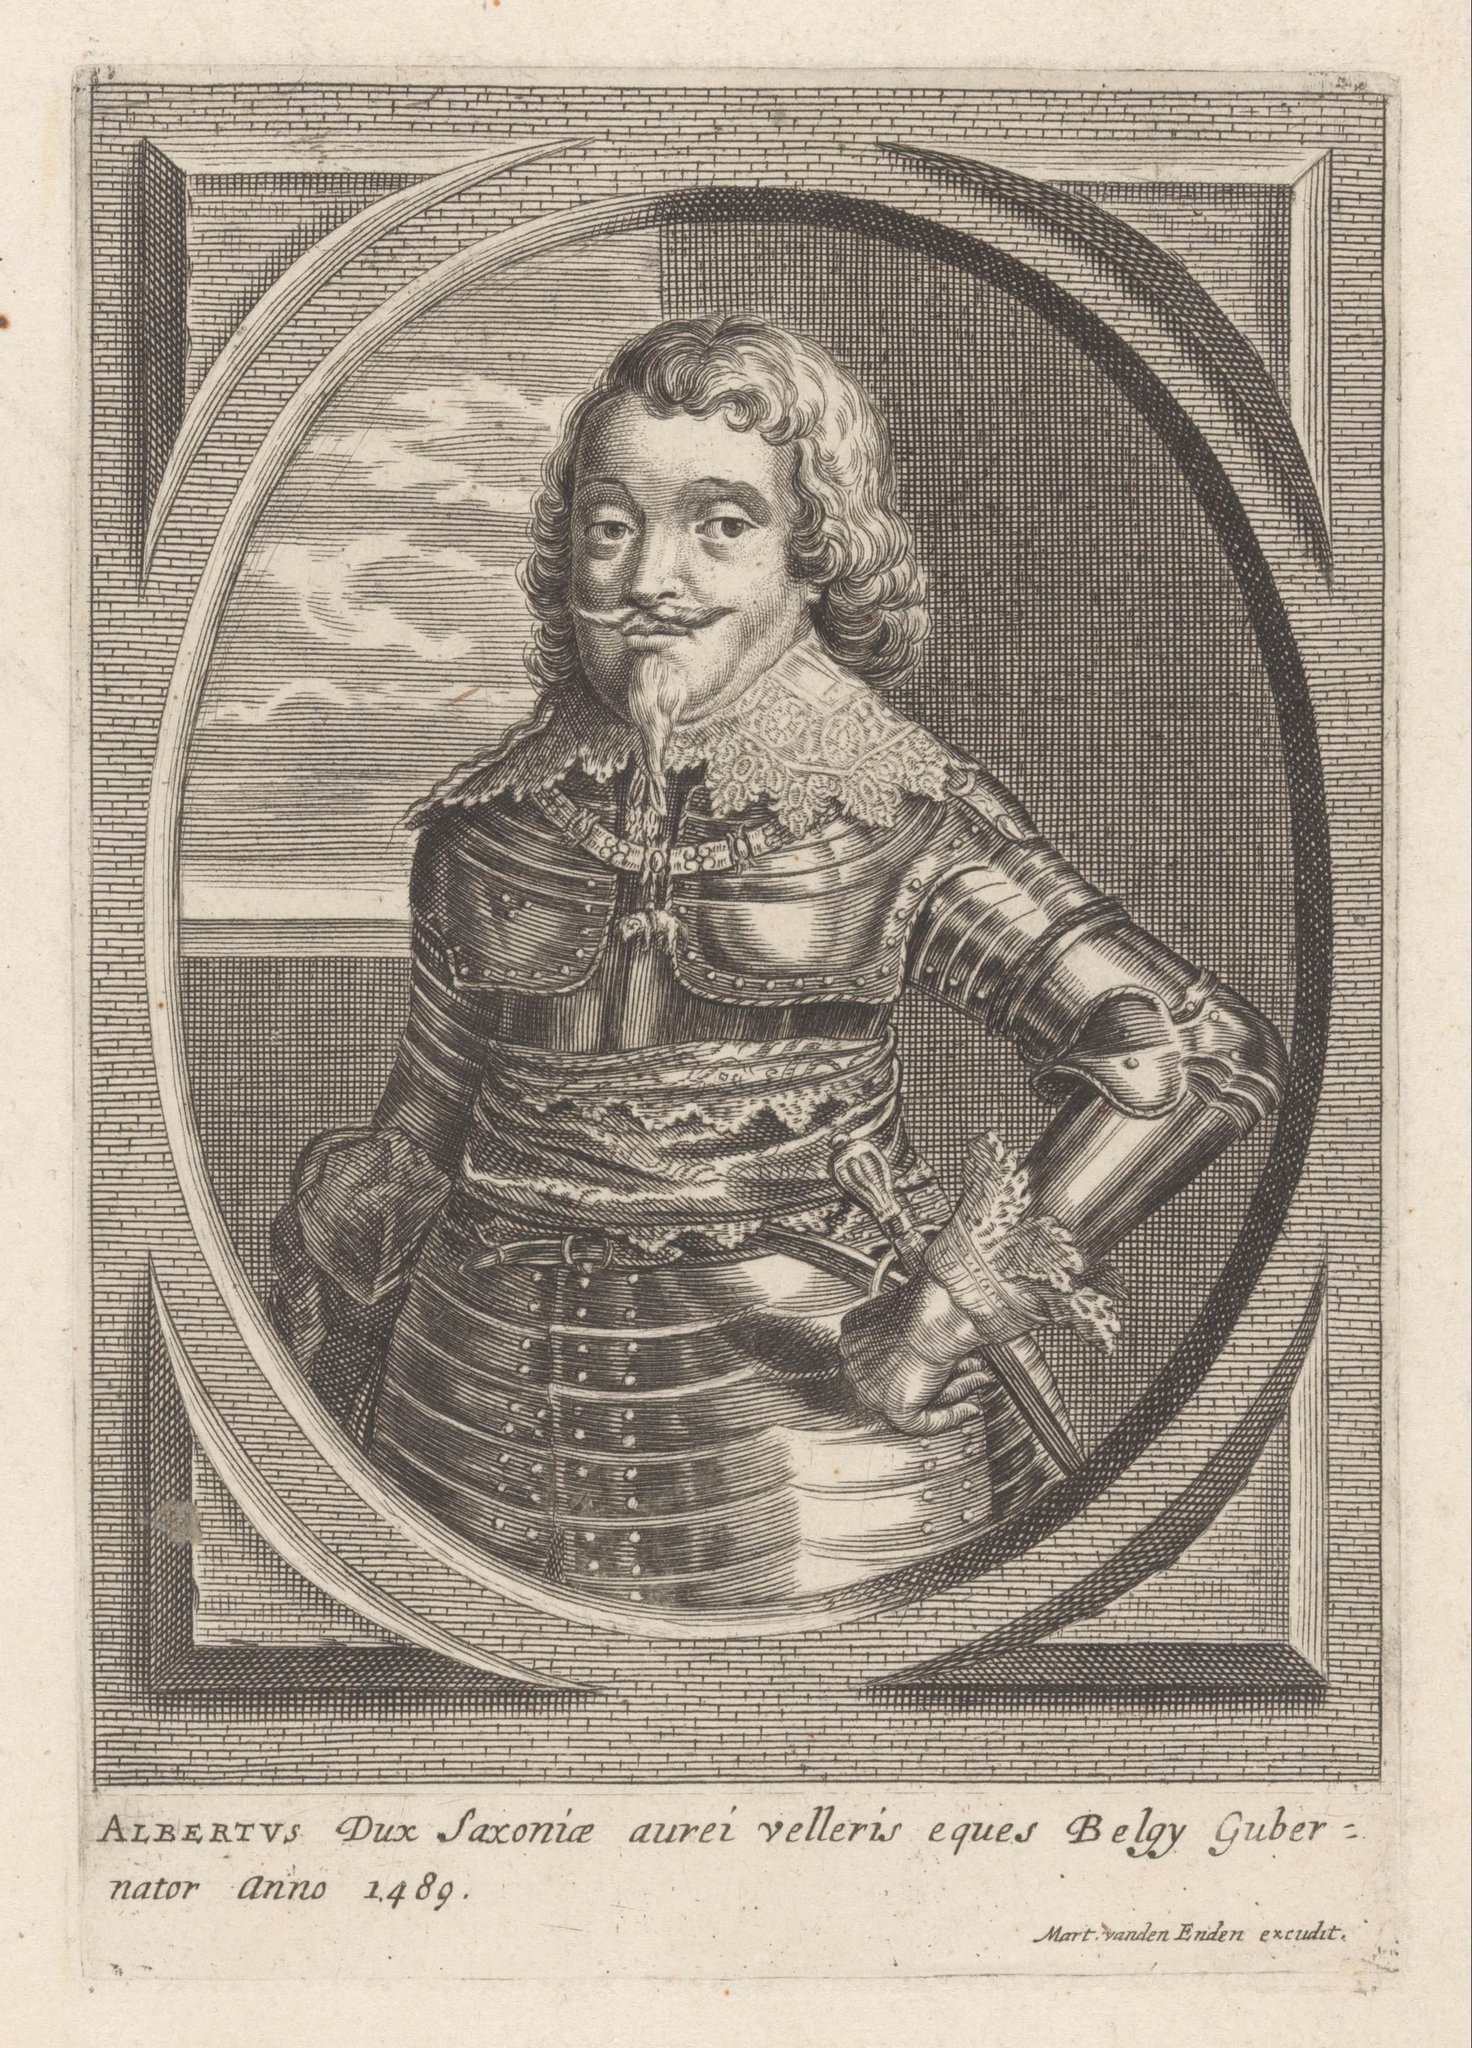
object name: print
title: Portret van Albrecht III, hertog van Saksen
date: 1630-1654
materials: paper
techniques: engraving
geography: antwerp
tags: grimma, emden, albrecht de kloekmoedige (hertog van saksen)